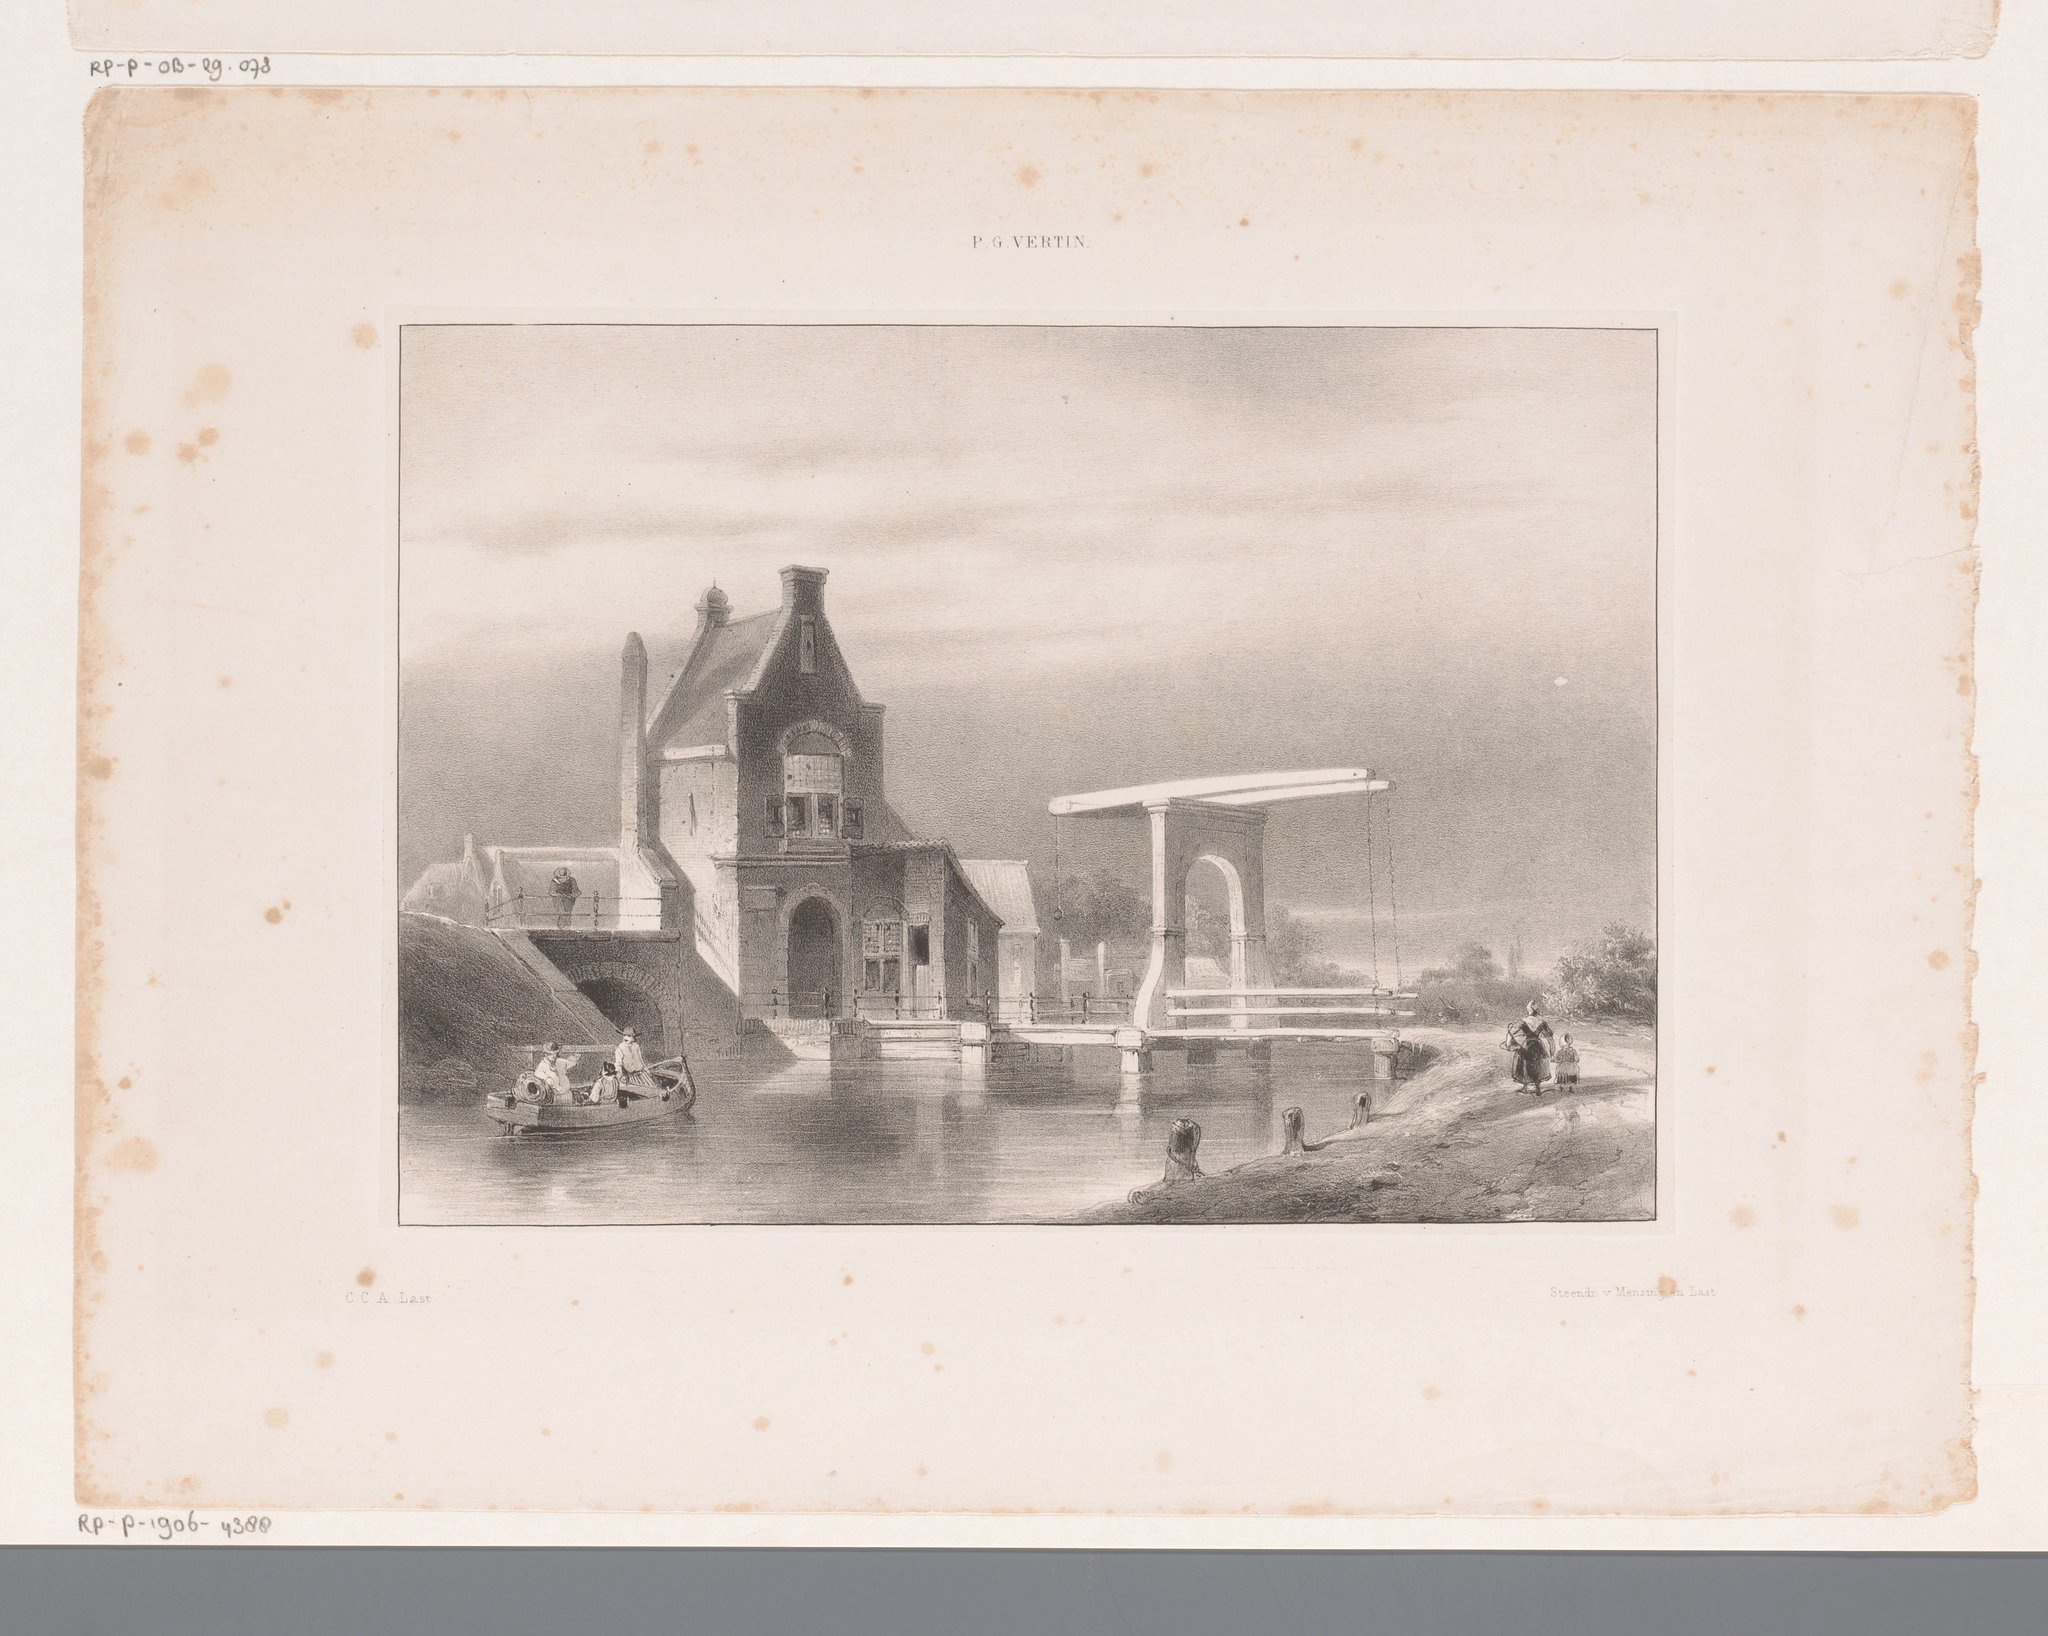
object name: print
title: Koepoort te Delft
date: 1841-1847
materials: paper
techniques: lithograph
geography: the hague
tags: drawbridge ~ fortified city, gate ~ fortified city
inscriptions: collector's mark: Lugt 2228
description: Op het water een boot met figuren, rechts op de weg naar de ophaalbrug lopen een moeder en kind.